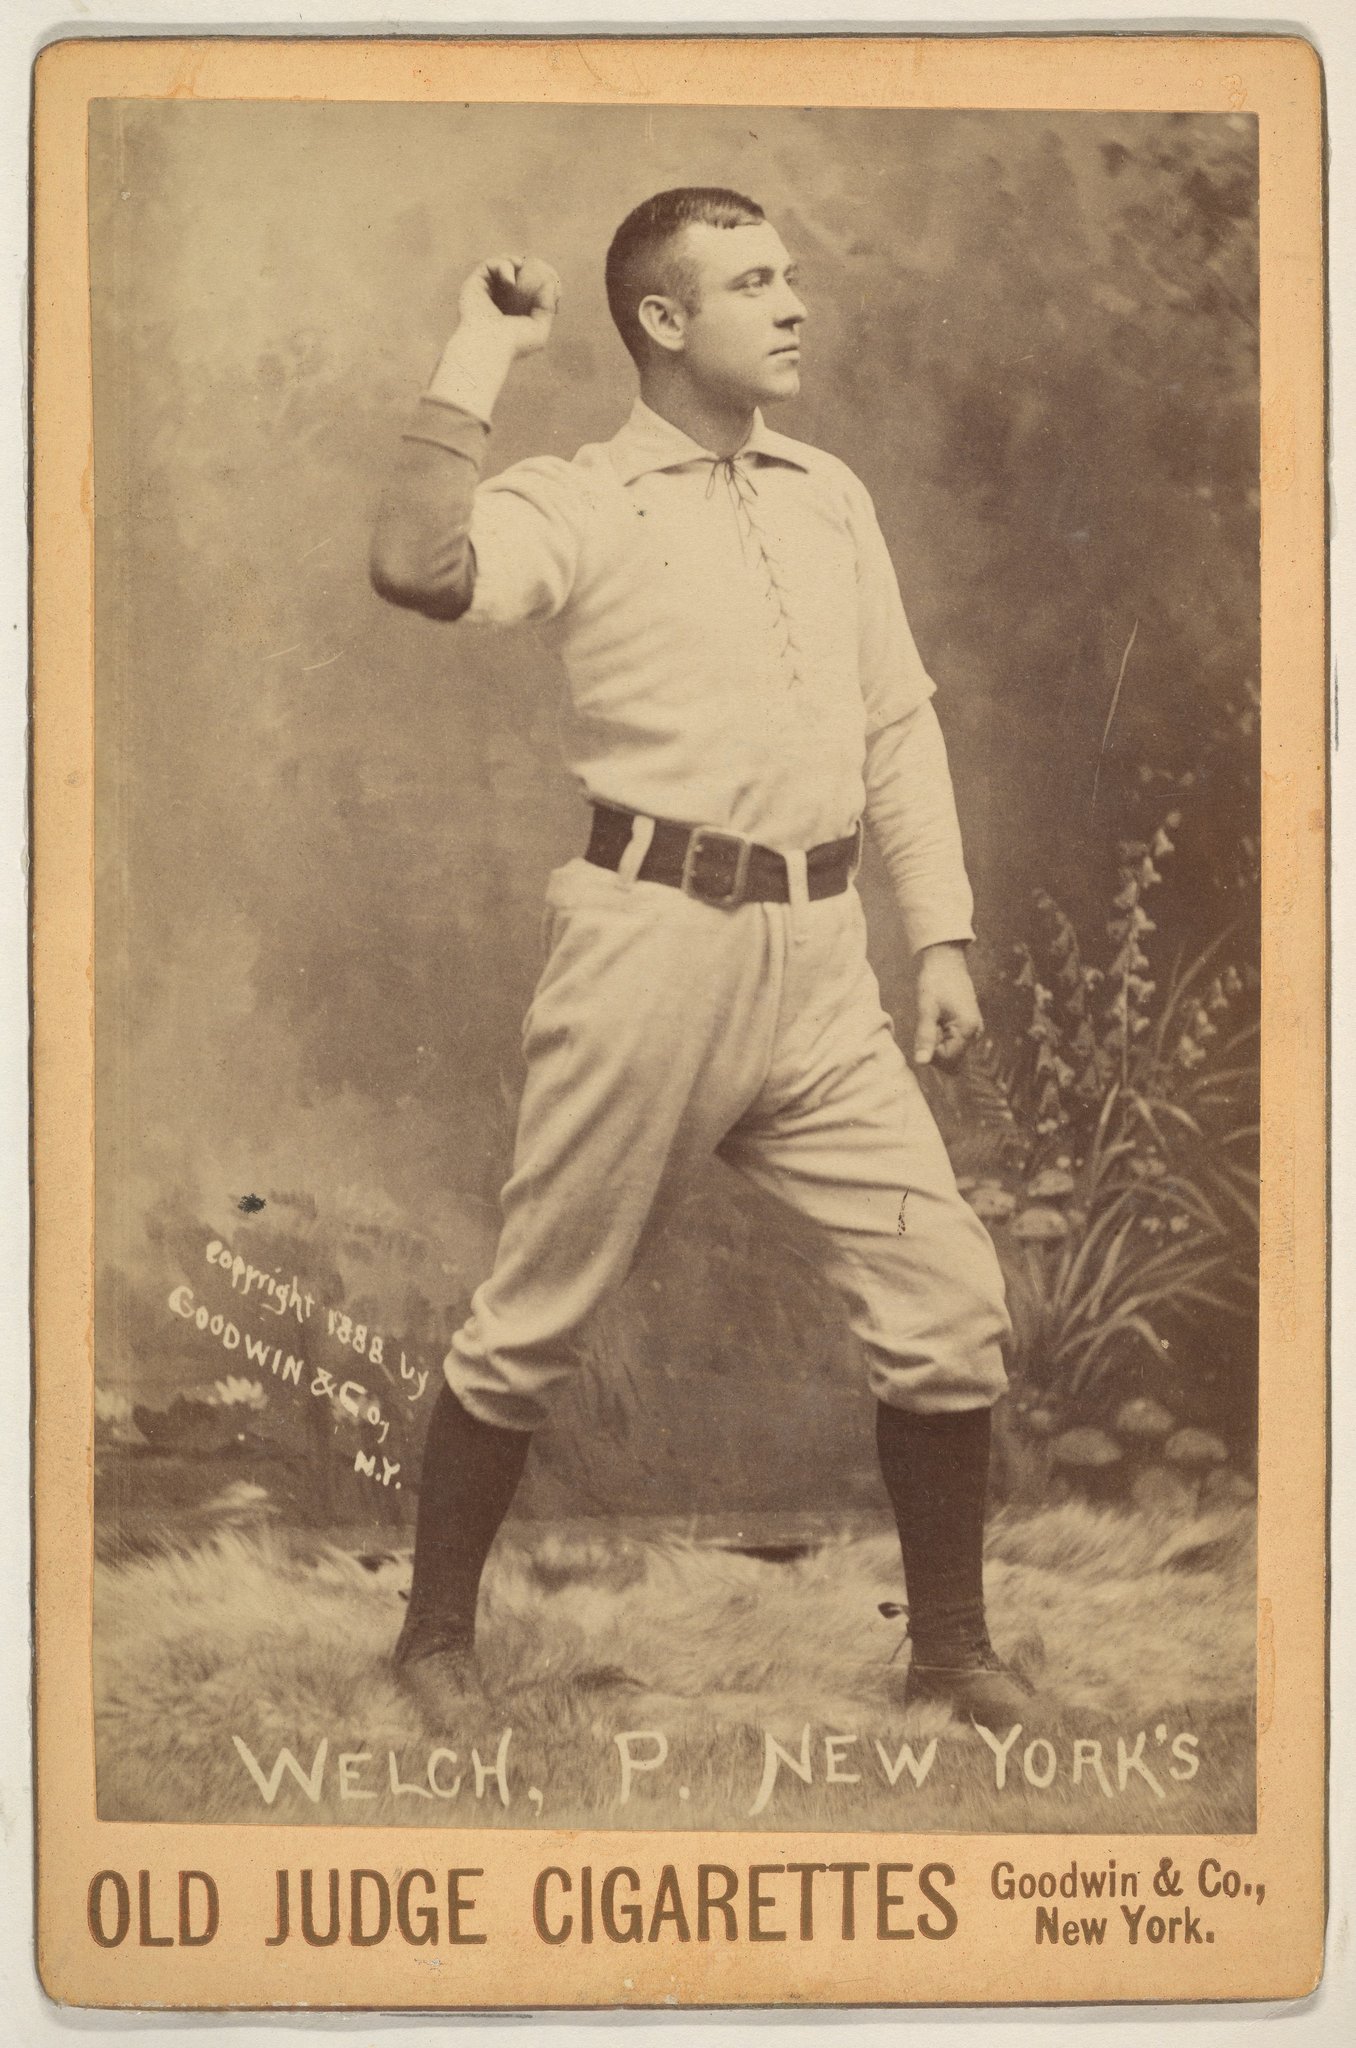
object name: baseball card, photograph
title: Welch, Pitcher, New York, from the series Old Judge Cigarettes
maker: goodwin & company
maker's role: publisher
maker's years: 1850-1950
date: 1888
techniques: albumen silver print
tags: men,portraits,baseball,athletes